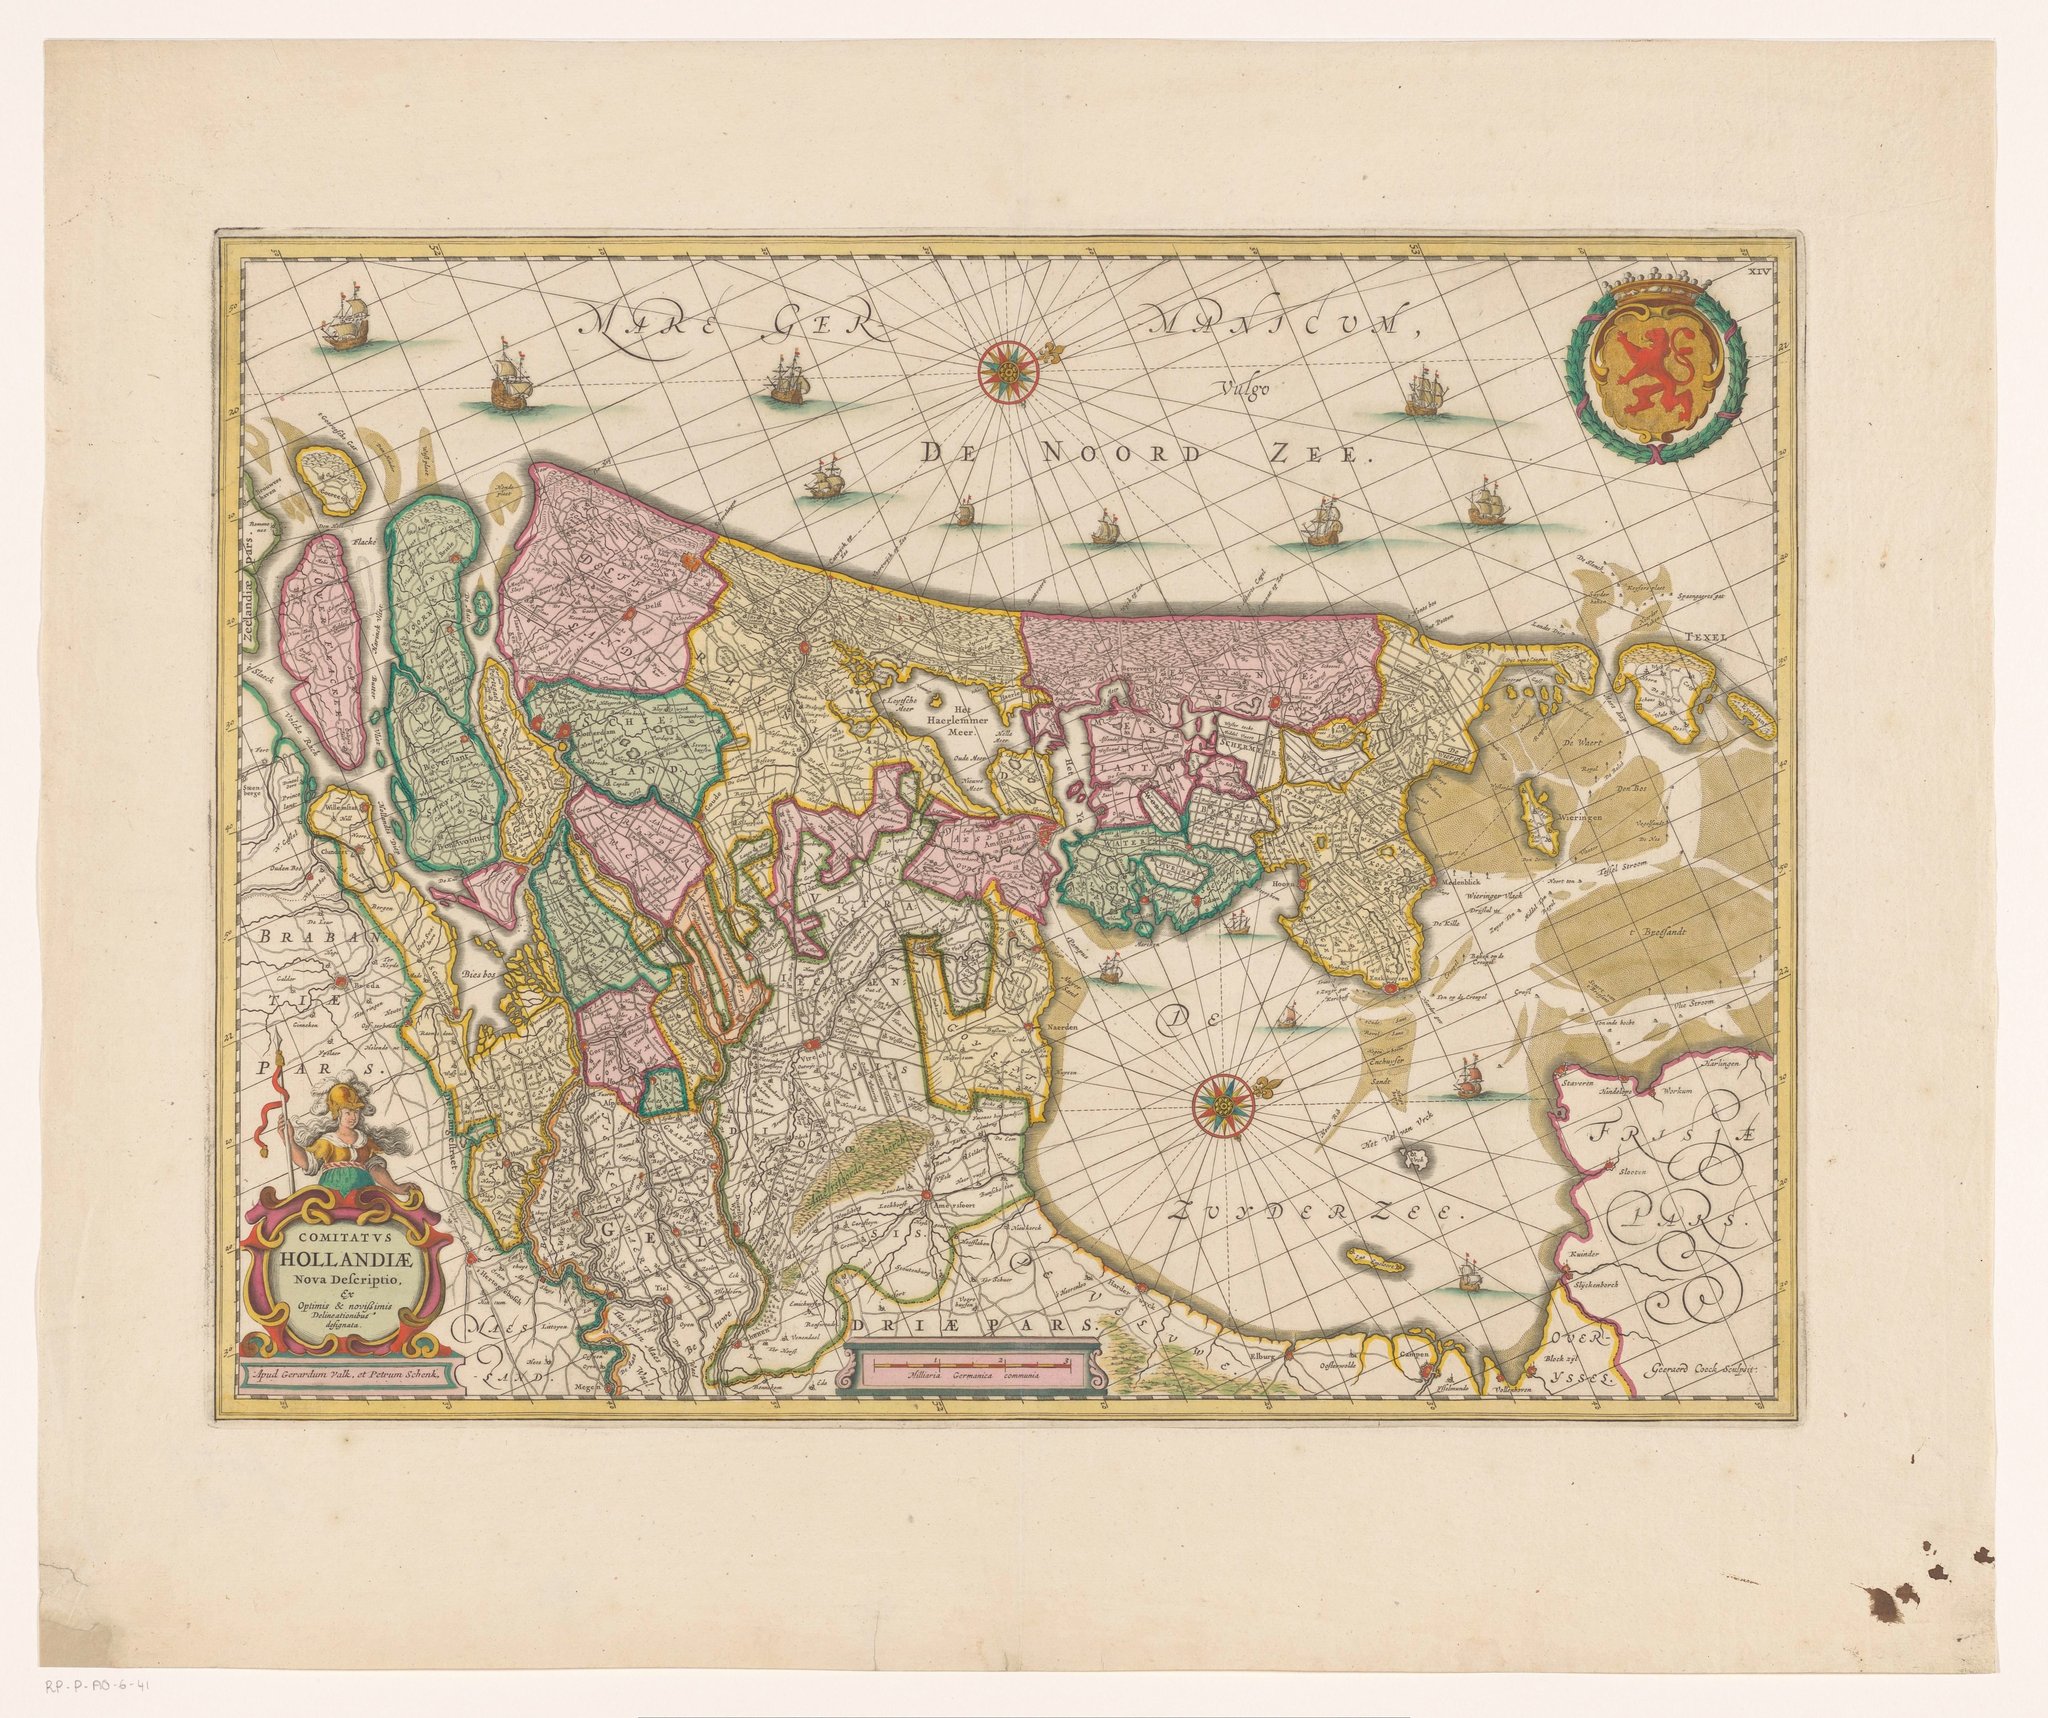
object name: print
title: Kaart van het graafschap Holland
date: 1680-1711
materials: paper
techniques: engraving, hand coloring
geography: amsterdam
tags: coat of arms (as symbol of the state, etc.), maps of separate countries or regions, holland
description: Kaart van het graafschap Holland en omliggende gebieden. Linksonder de titelcartouche. Onderaan in het midden een schaalstok: Milliaria Germanica communia. Rechtsboven het wapen van het graafschap Holland in een lauwerkrans. Gradenverdeling langs de randen. Oriëntatie: noorden rechts.